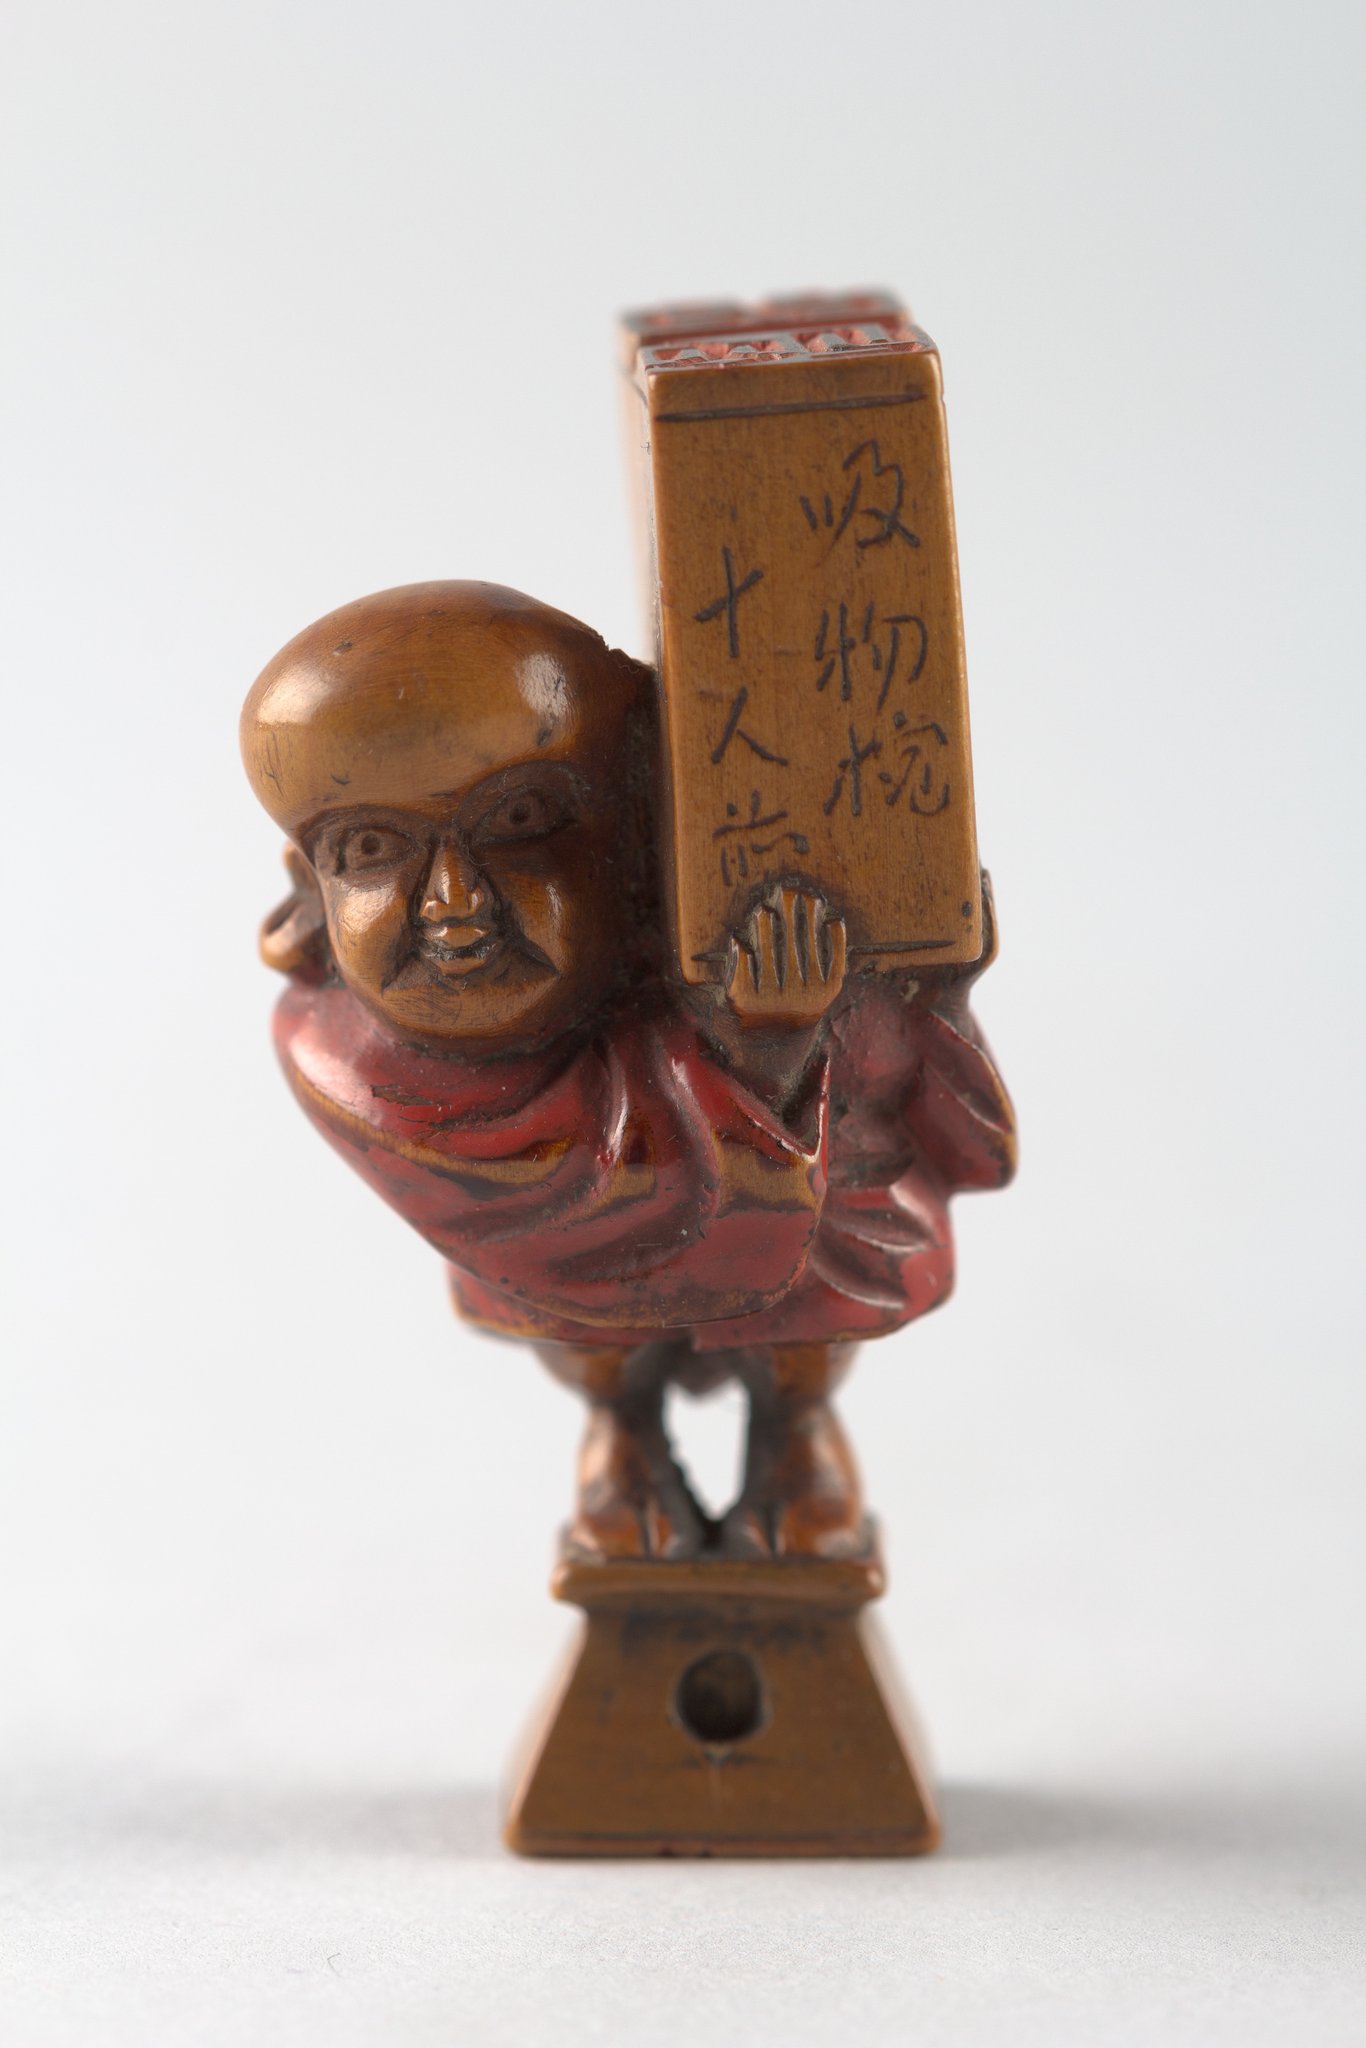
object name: netsuke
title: Netsuke and Seal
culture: japanese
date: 1701-1800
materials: lacquer, wood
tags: human figures